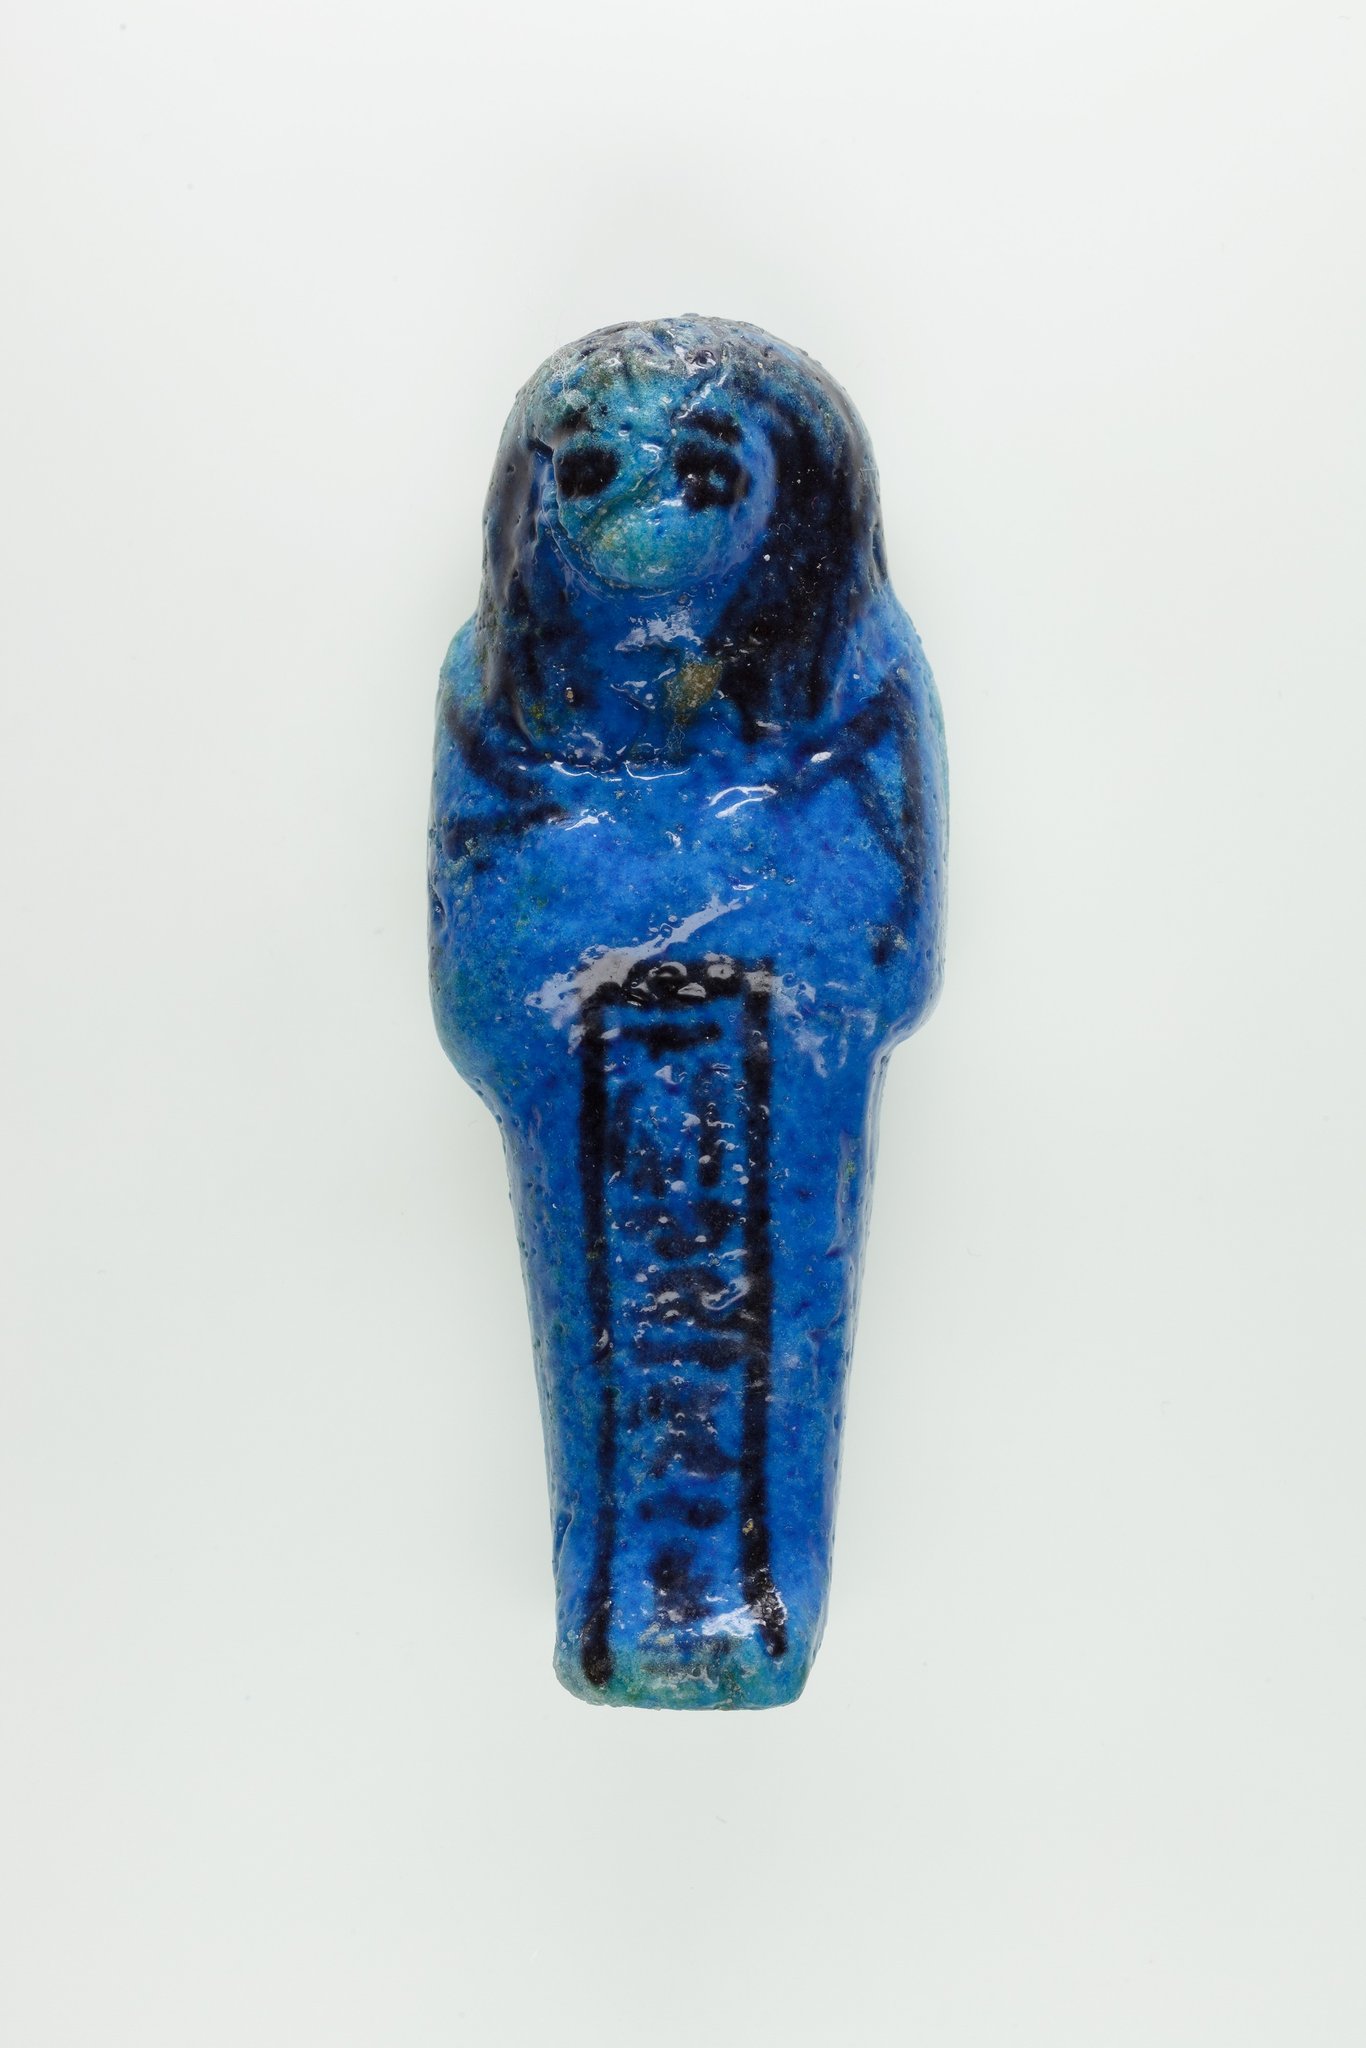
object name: shabti, worker, nauny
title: Worker Shabti of Nauny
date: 1050 BCE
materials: faience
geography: egypt